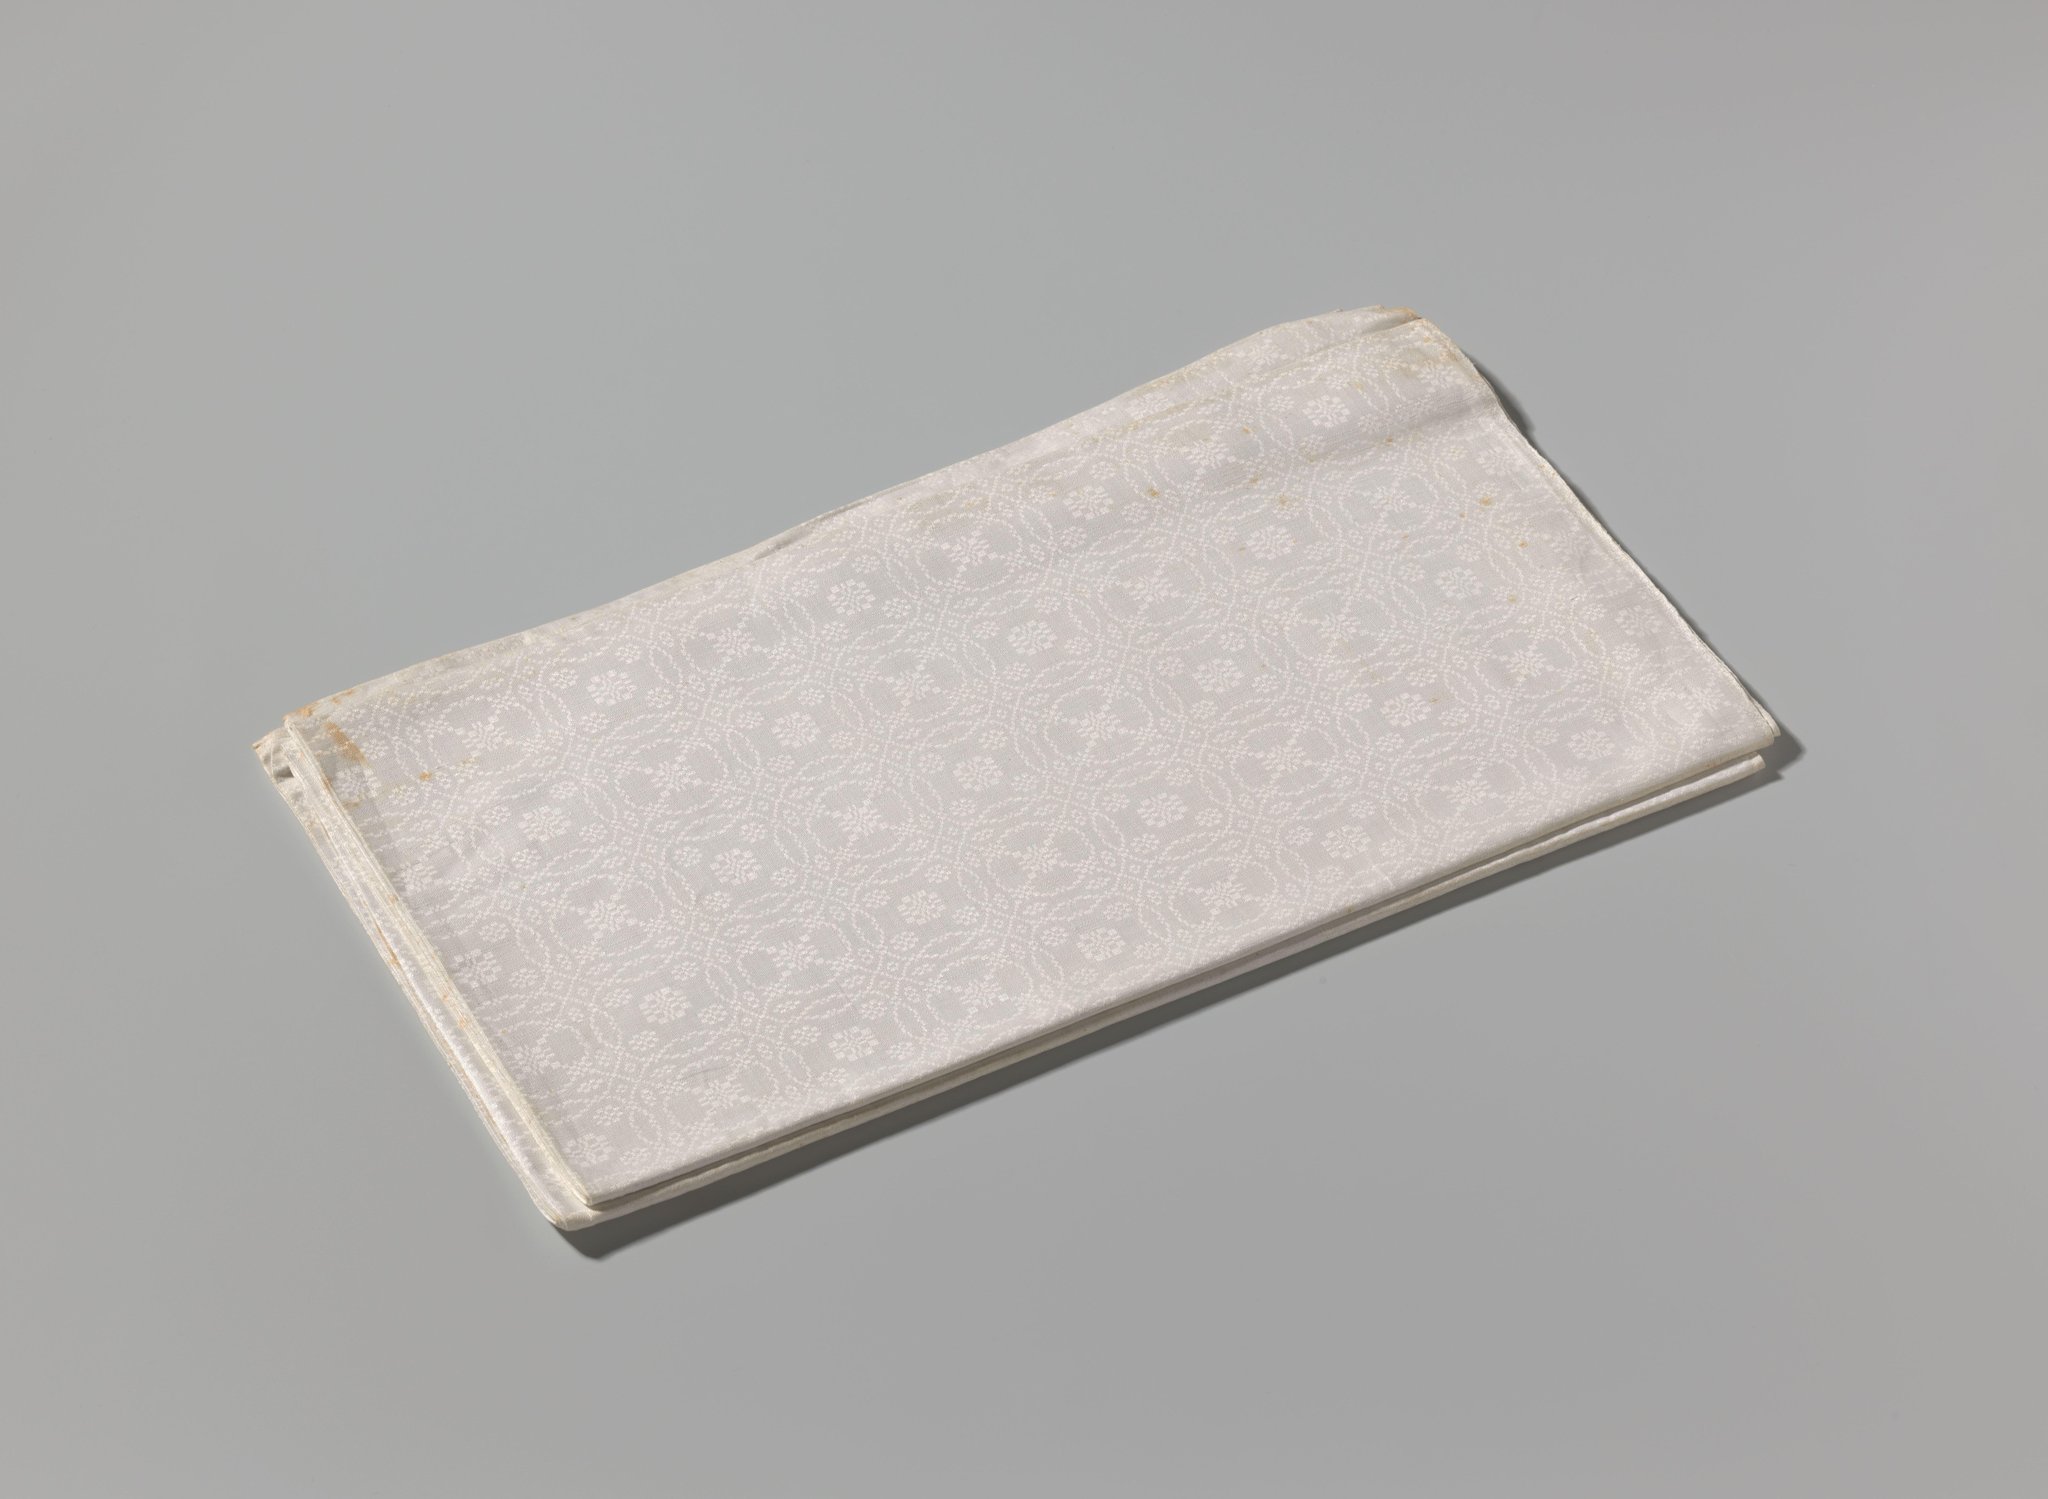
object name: tablecloth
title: Tafellaken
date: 1690-1710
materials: linen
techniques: peeled fabric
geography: northern netherlands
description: Wit linnen tafellaken met pellen patroon. Merk HW.